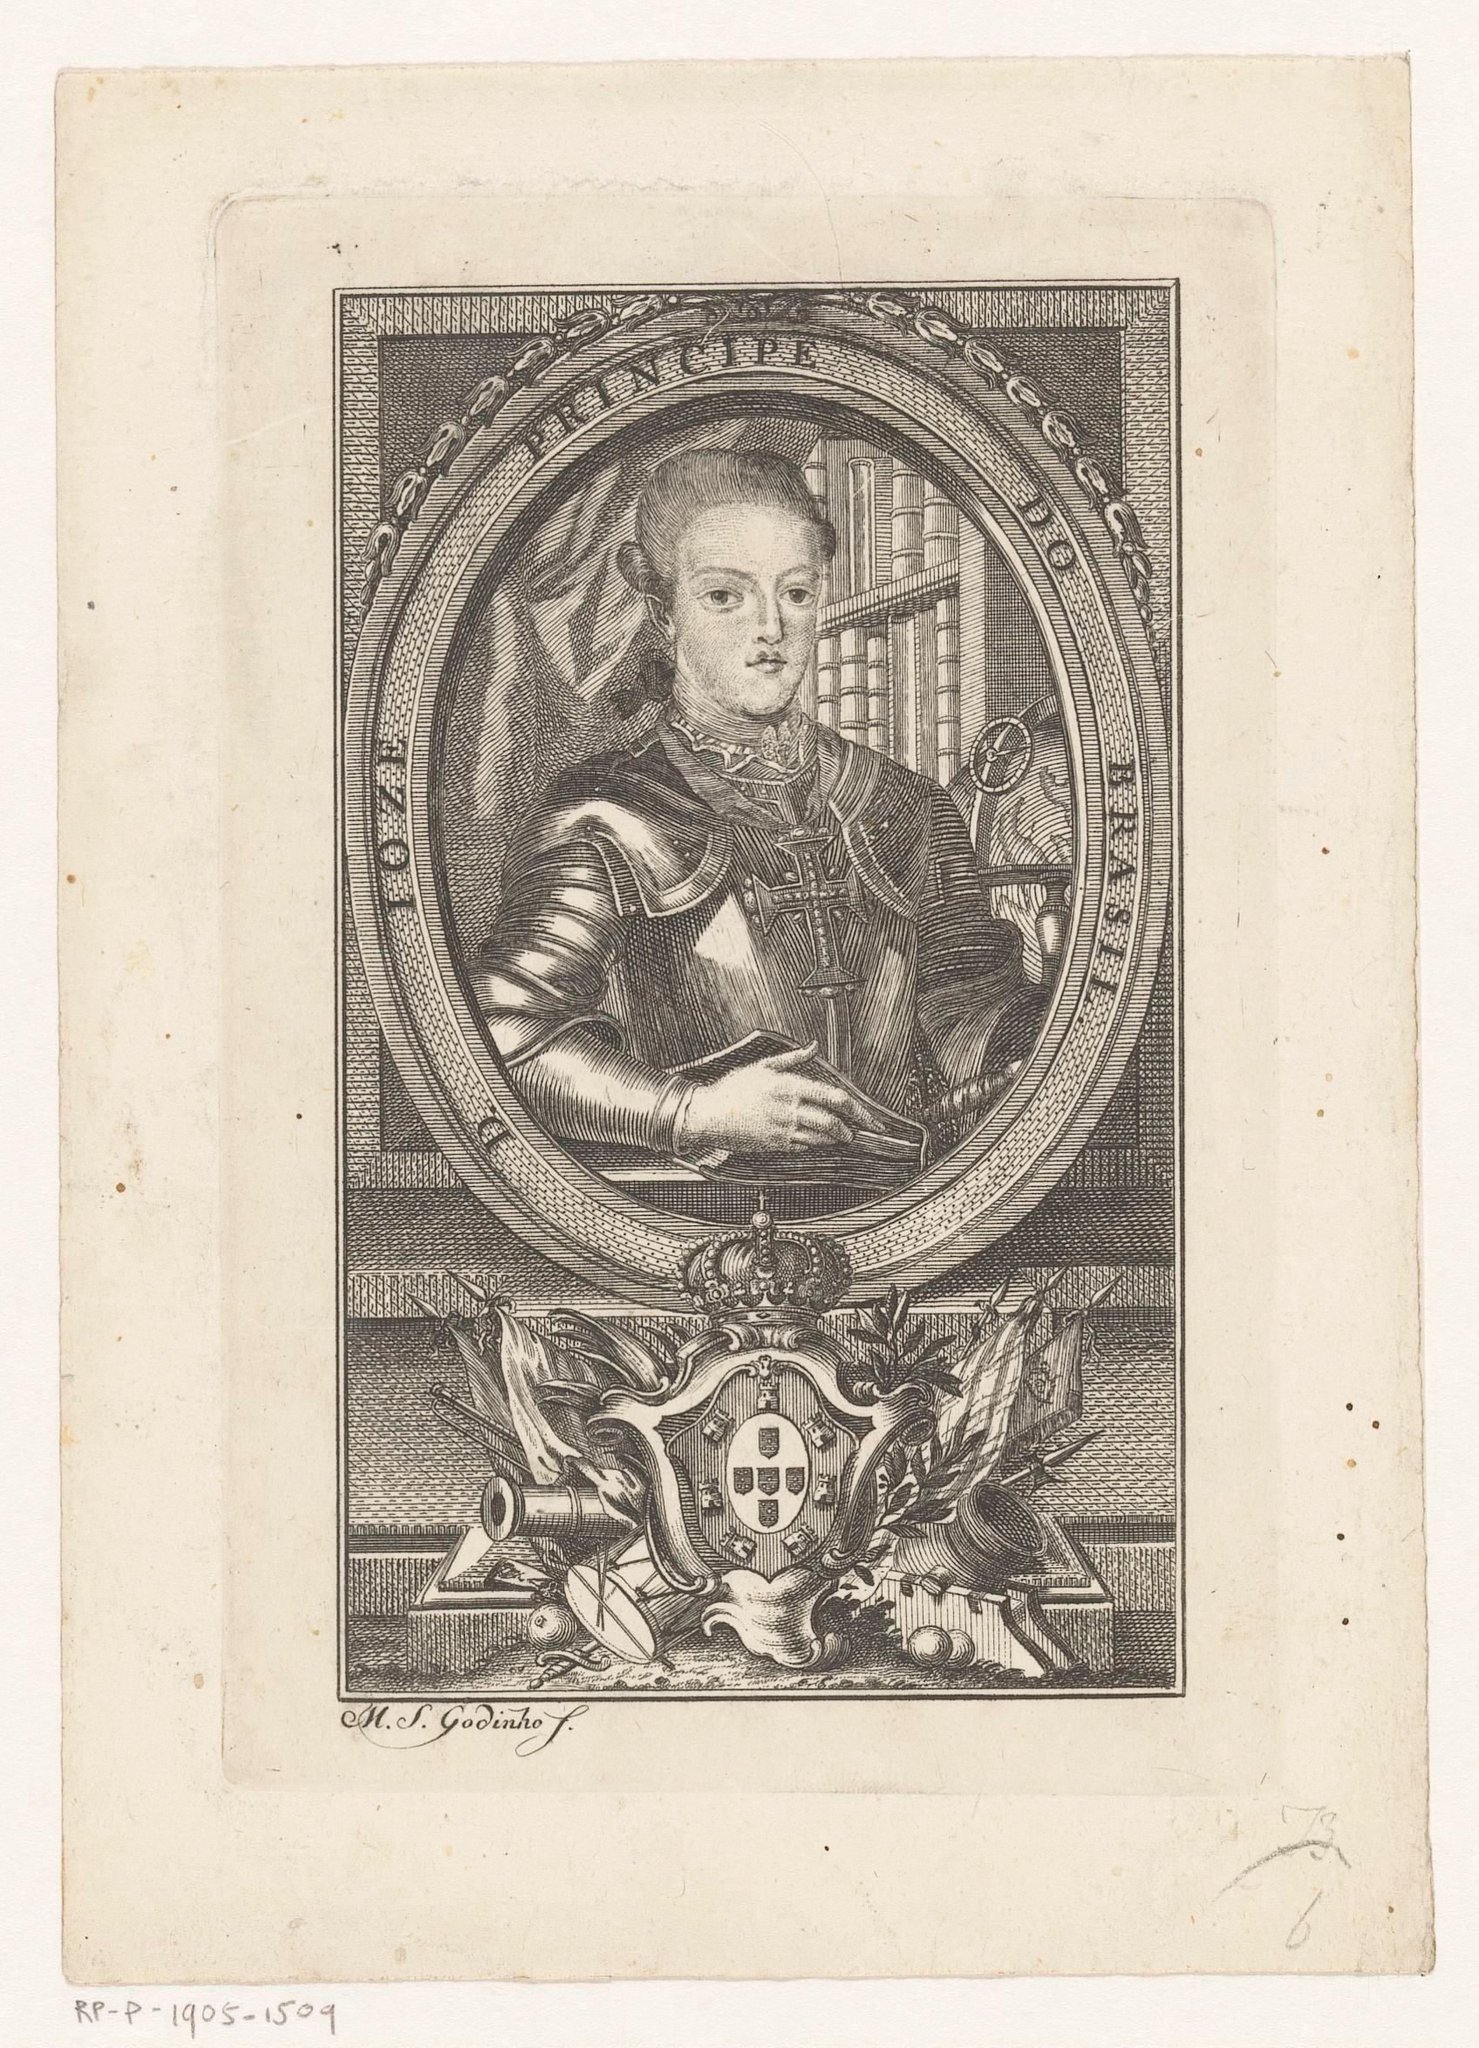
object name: print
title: Portret van José, prins van Brazilië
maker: manuel da silva godinho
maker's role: print maker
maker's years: 1751-1799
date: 1761-1799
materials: paper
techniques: etching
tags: historical persons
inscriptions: collector's mark: Lugt 2228